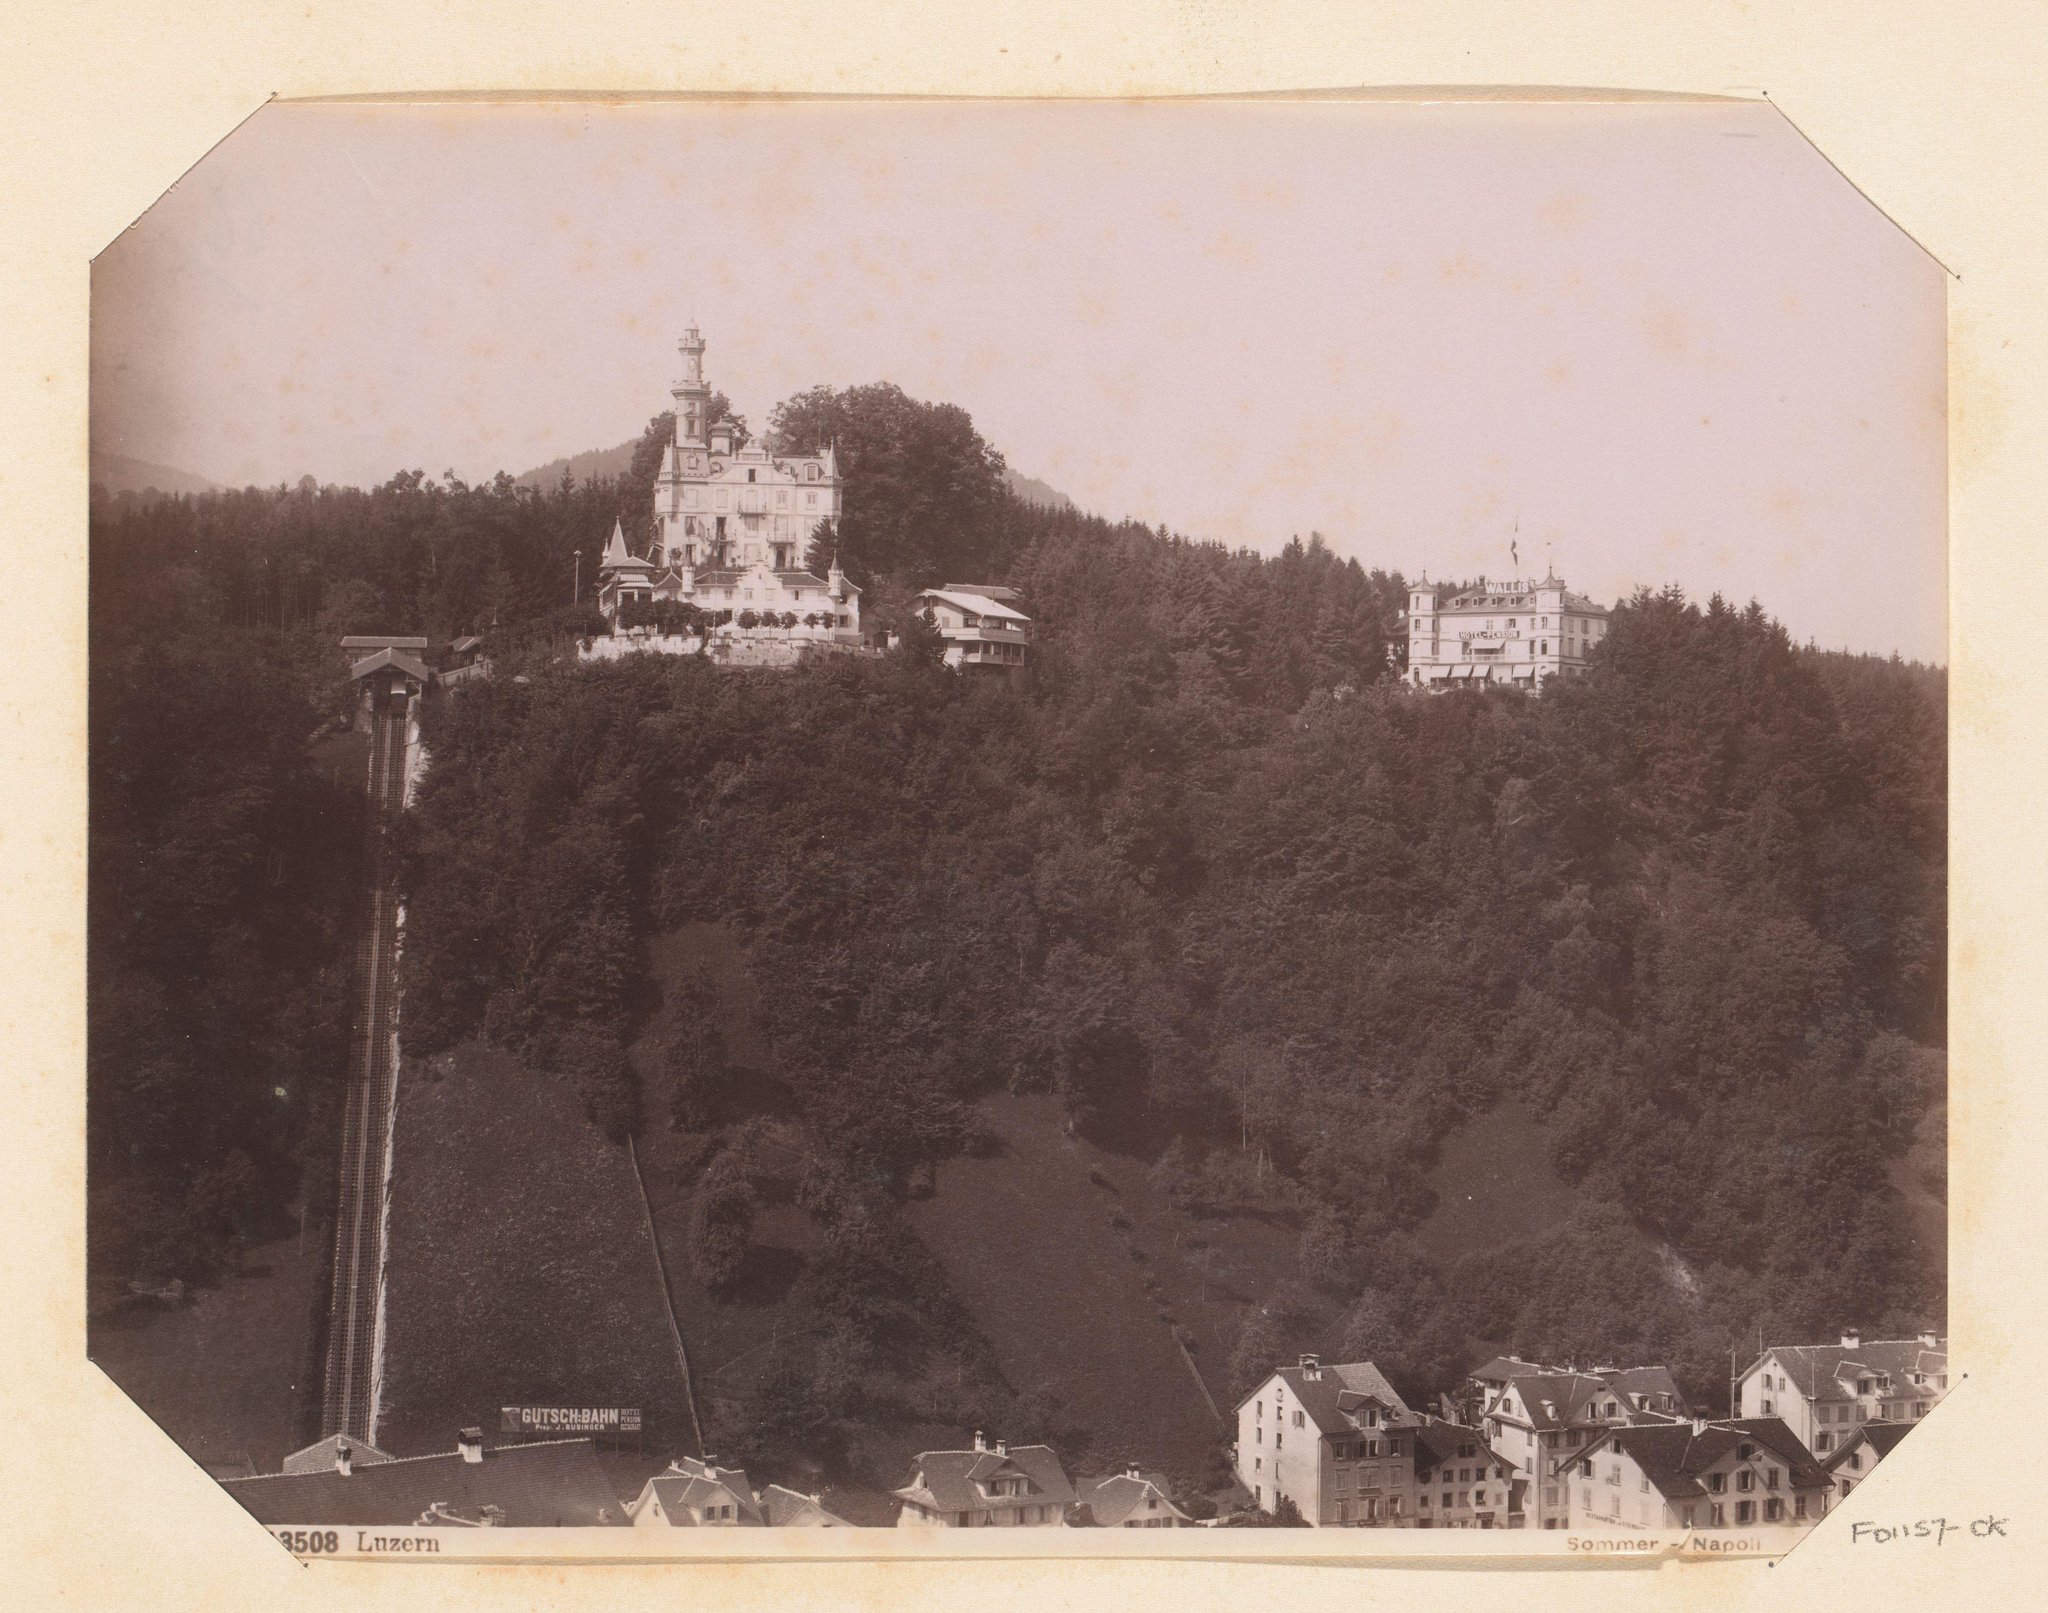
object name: album leaf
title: Luzern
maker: giorgio sommer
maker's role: fotograaf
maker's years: 1834-1914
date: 1885-1892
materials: photographic support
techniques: albumen print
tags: trees, castle, funicular railway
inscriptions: annotation: ‘Lucerne Gütschbahn’, number: ‘13508’